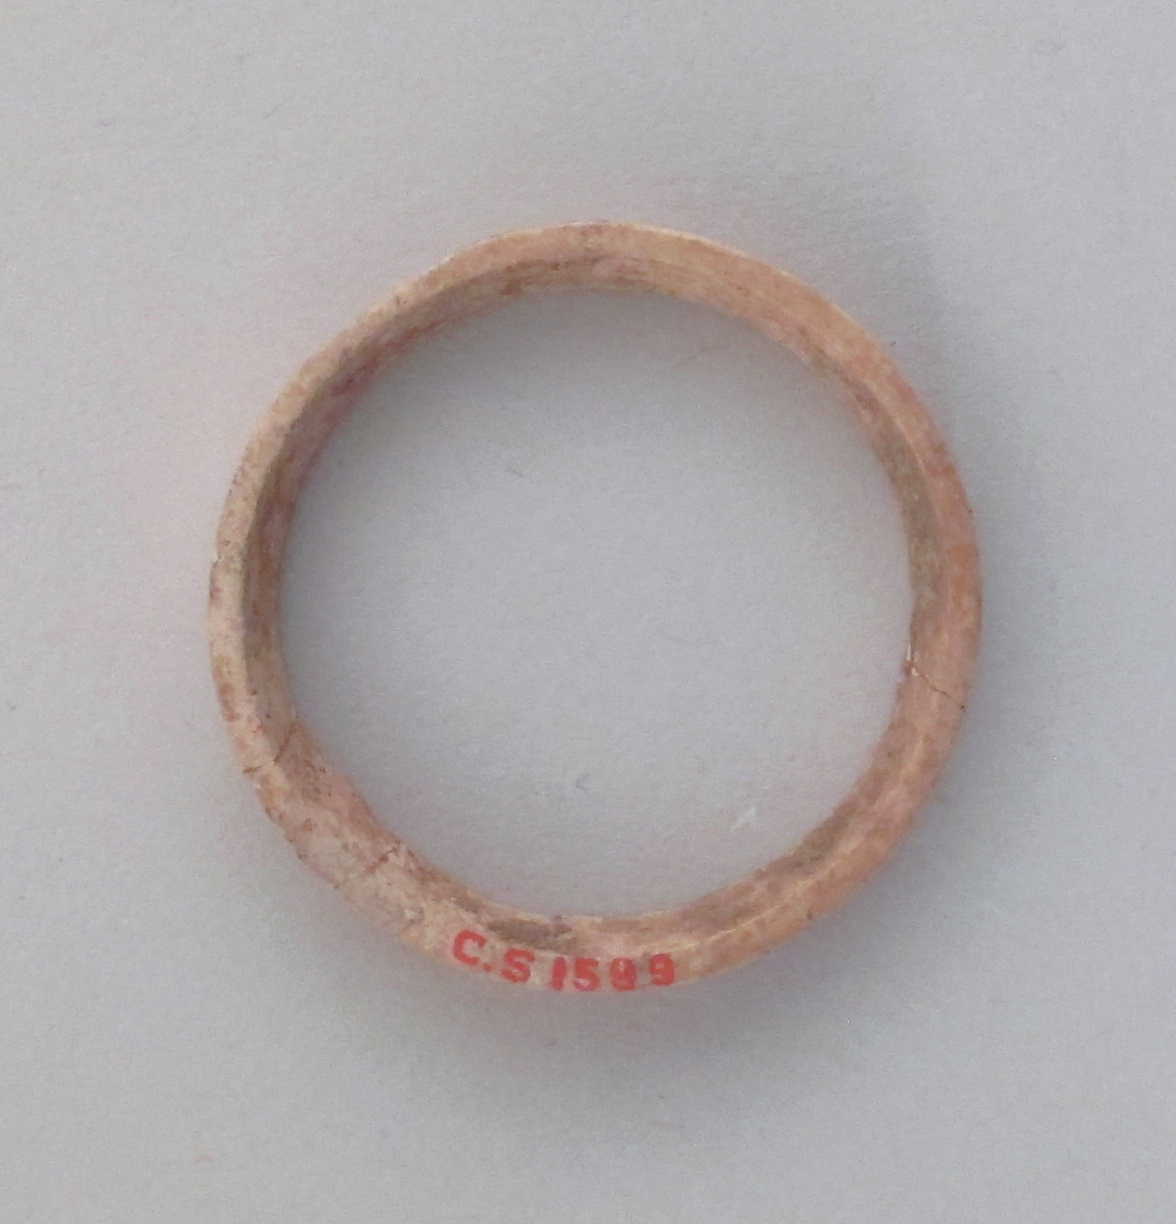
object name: ring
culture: cypriot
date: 7000 BCE-330 CE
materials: bone